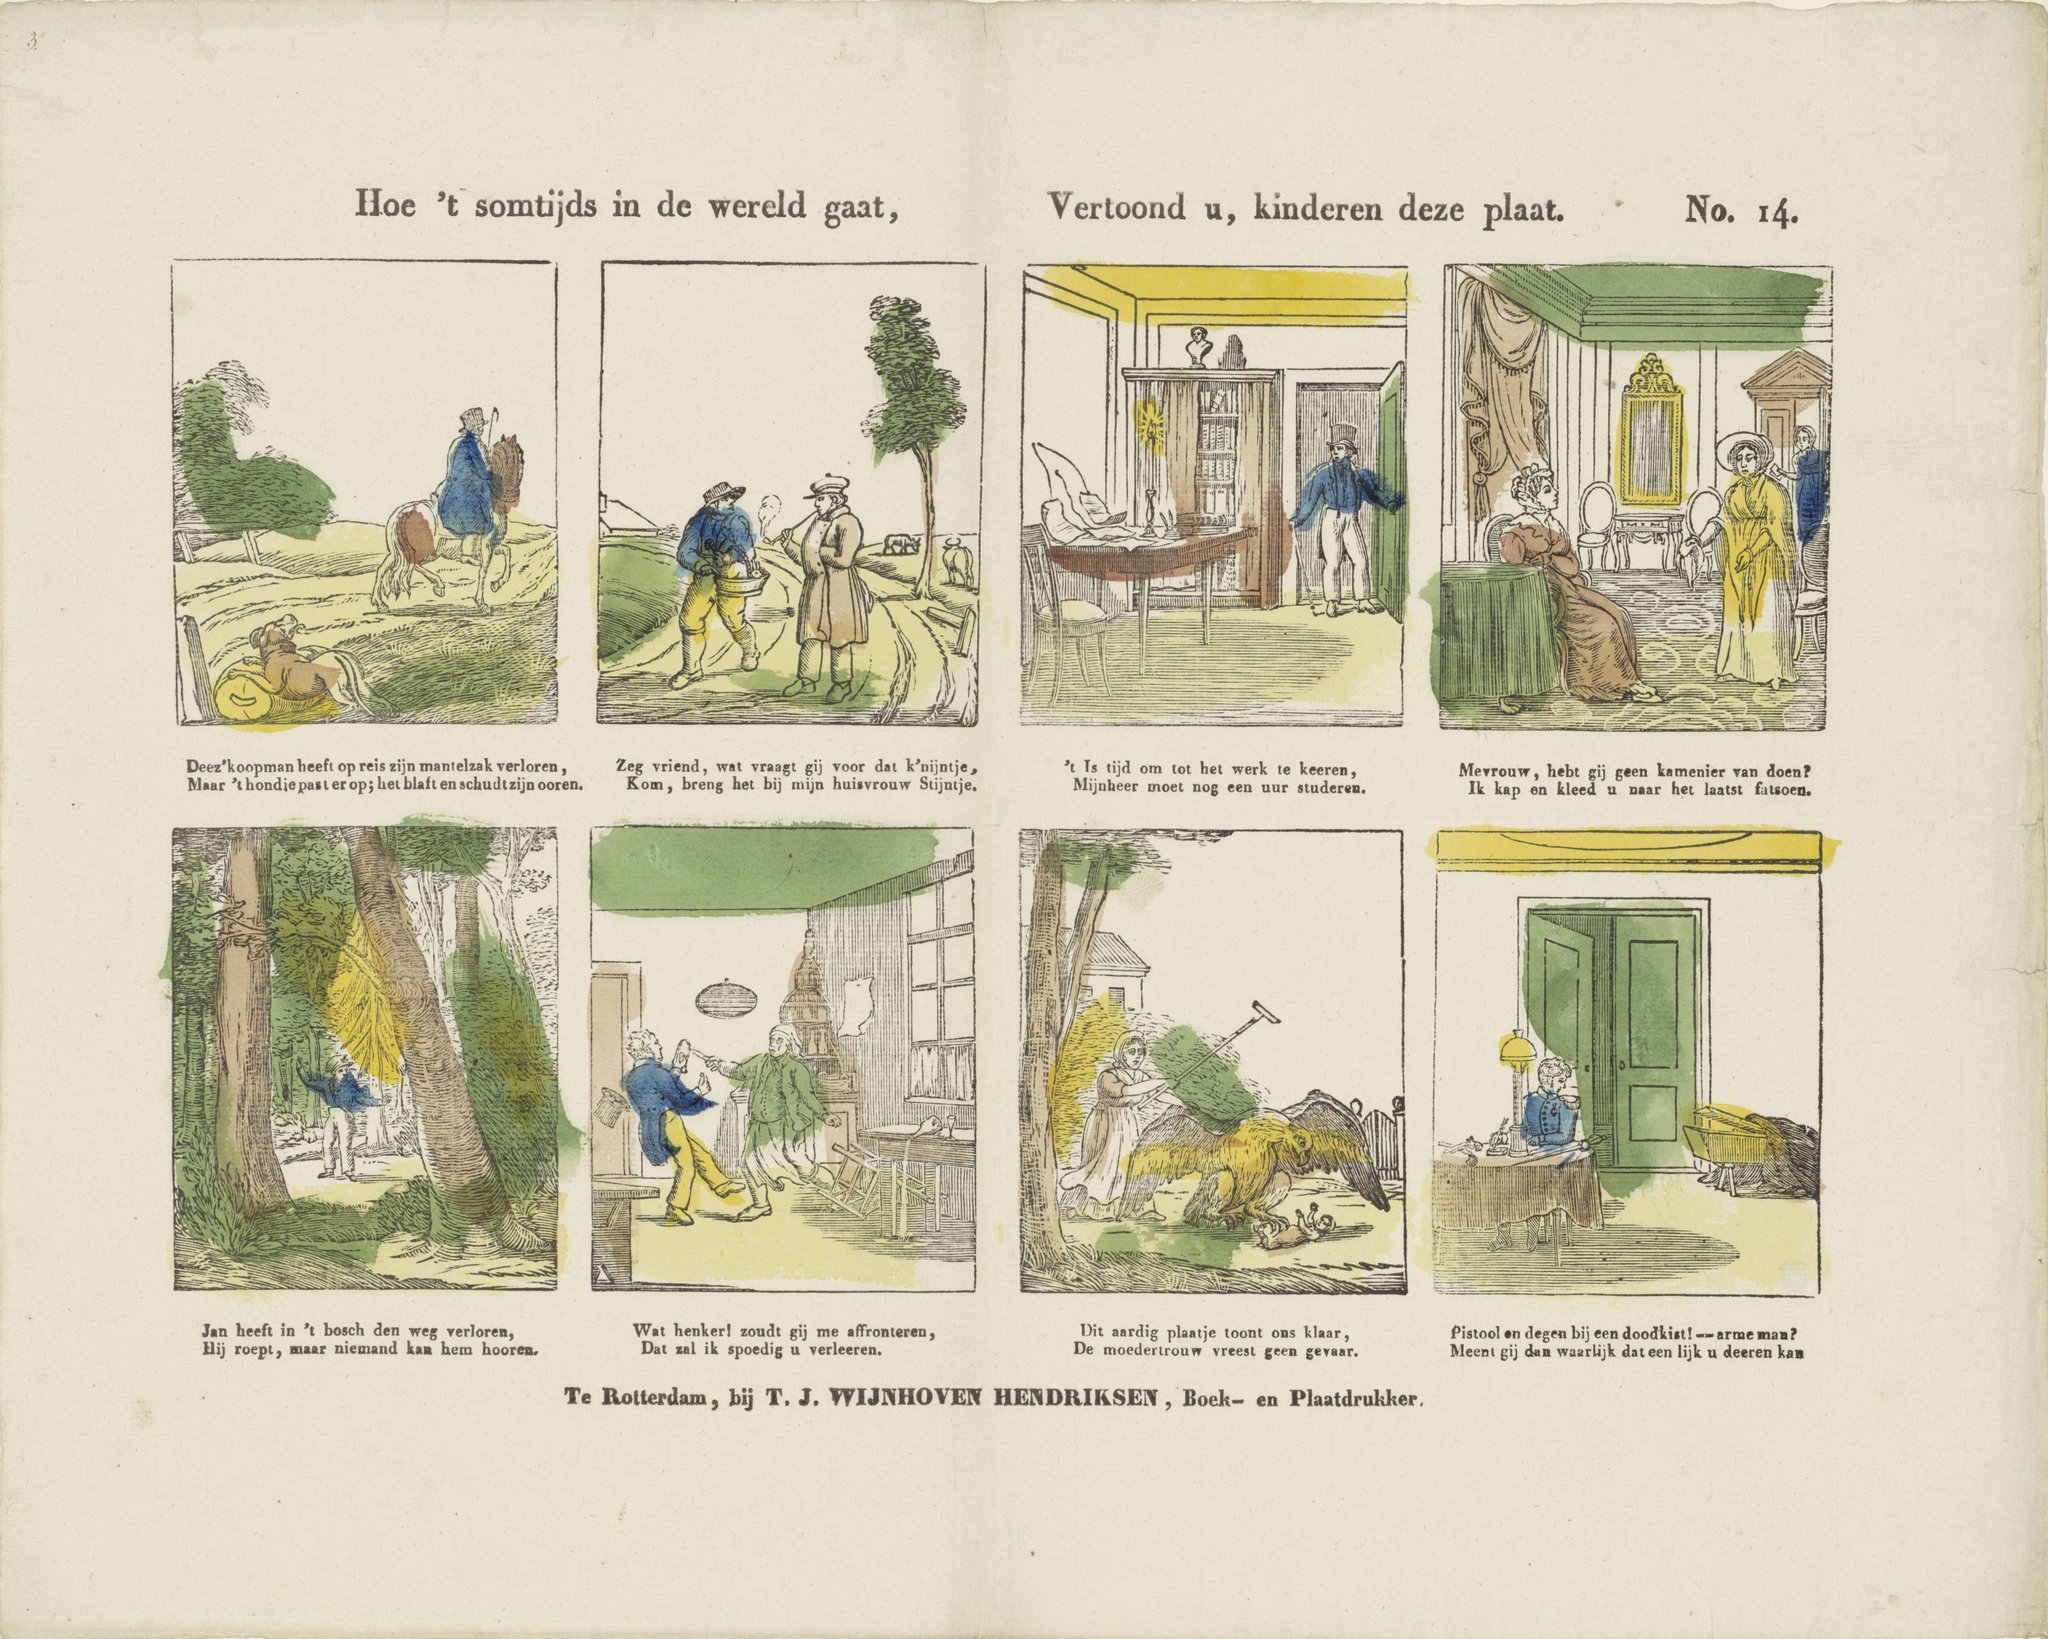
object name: popular print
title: Hoe 't somtijds in de wereld gaat, / vertoond u, kinderen deze plaat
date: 1832-1850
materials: paper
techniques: colour, letterpress printing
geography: rotterdam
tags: scholar in his study, 'motherly care', delousing (+ protecting)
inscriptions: collector's mark: Lugt 2760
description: Blad met 8 voorstellingen van verschillende figuren en bezigheden, waaronder een man in zijn studeerkamer en een moeder die haar baby redt van een adelaar. Onder elke voorstelling een tweeregelig vers. Genummerd rechtsboven: No. 14.